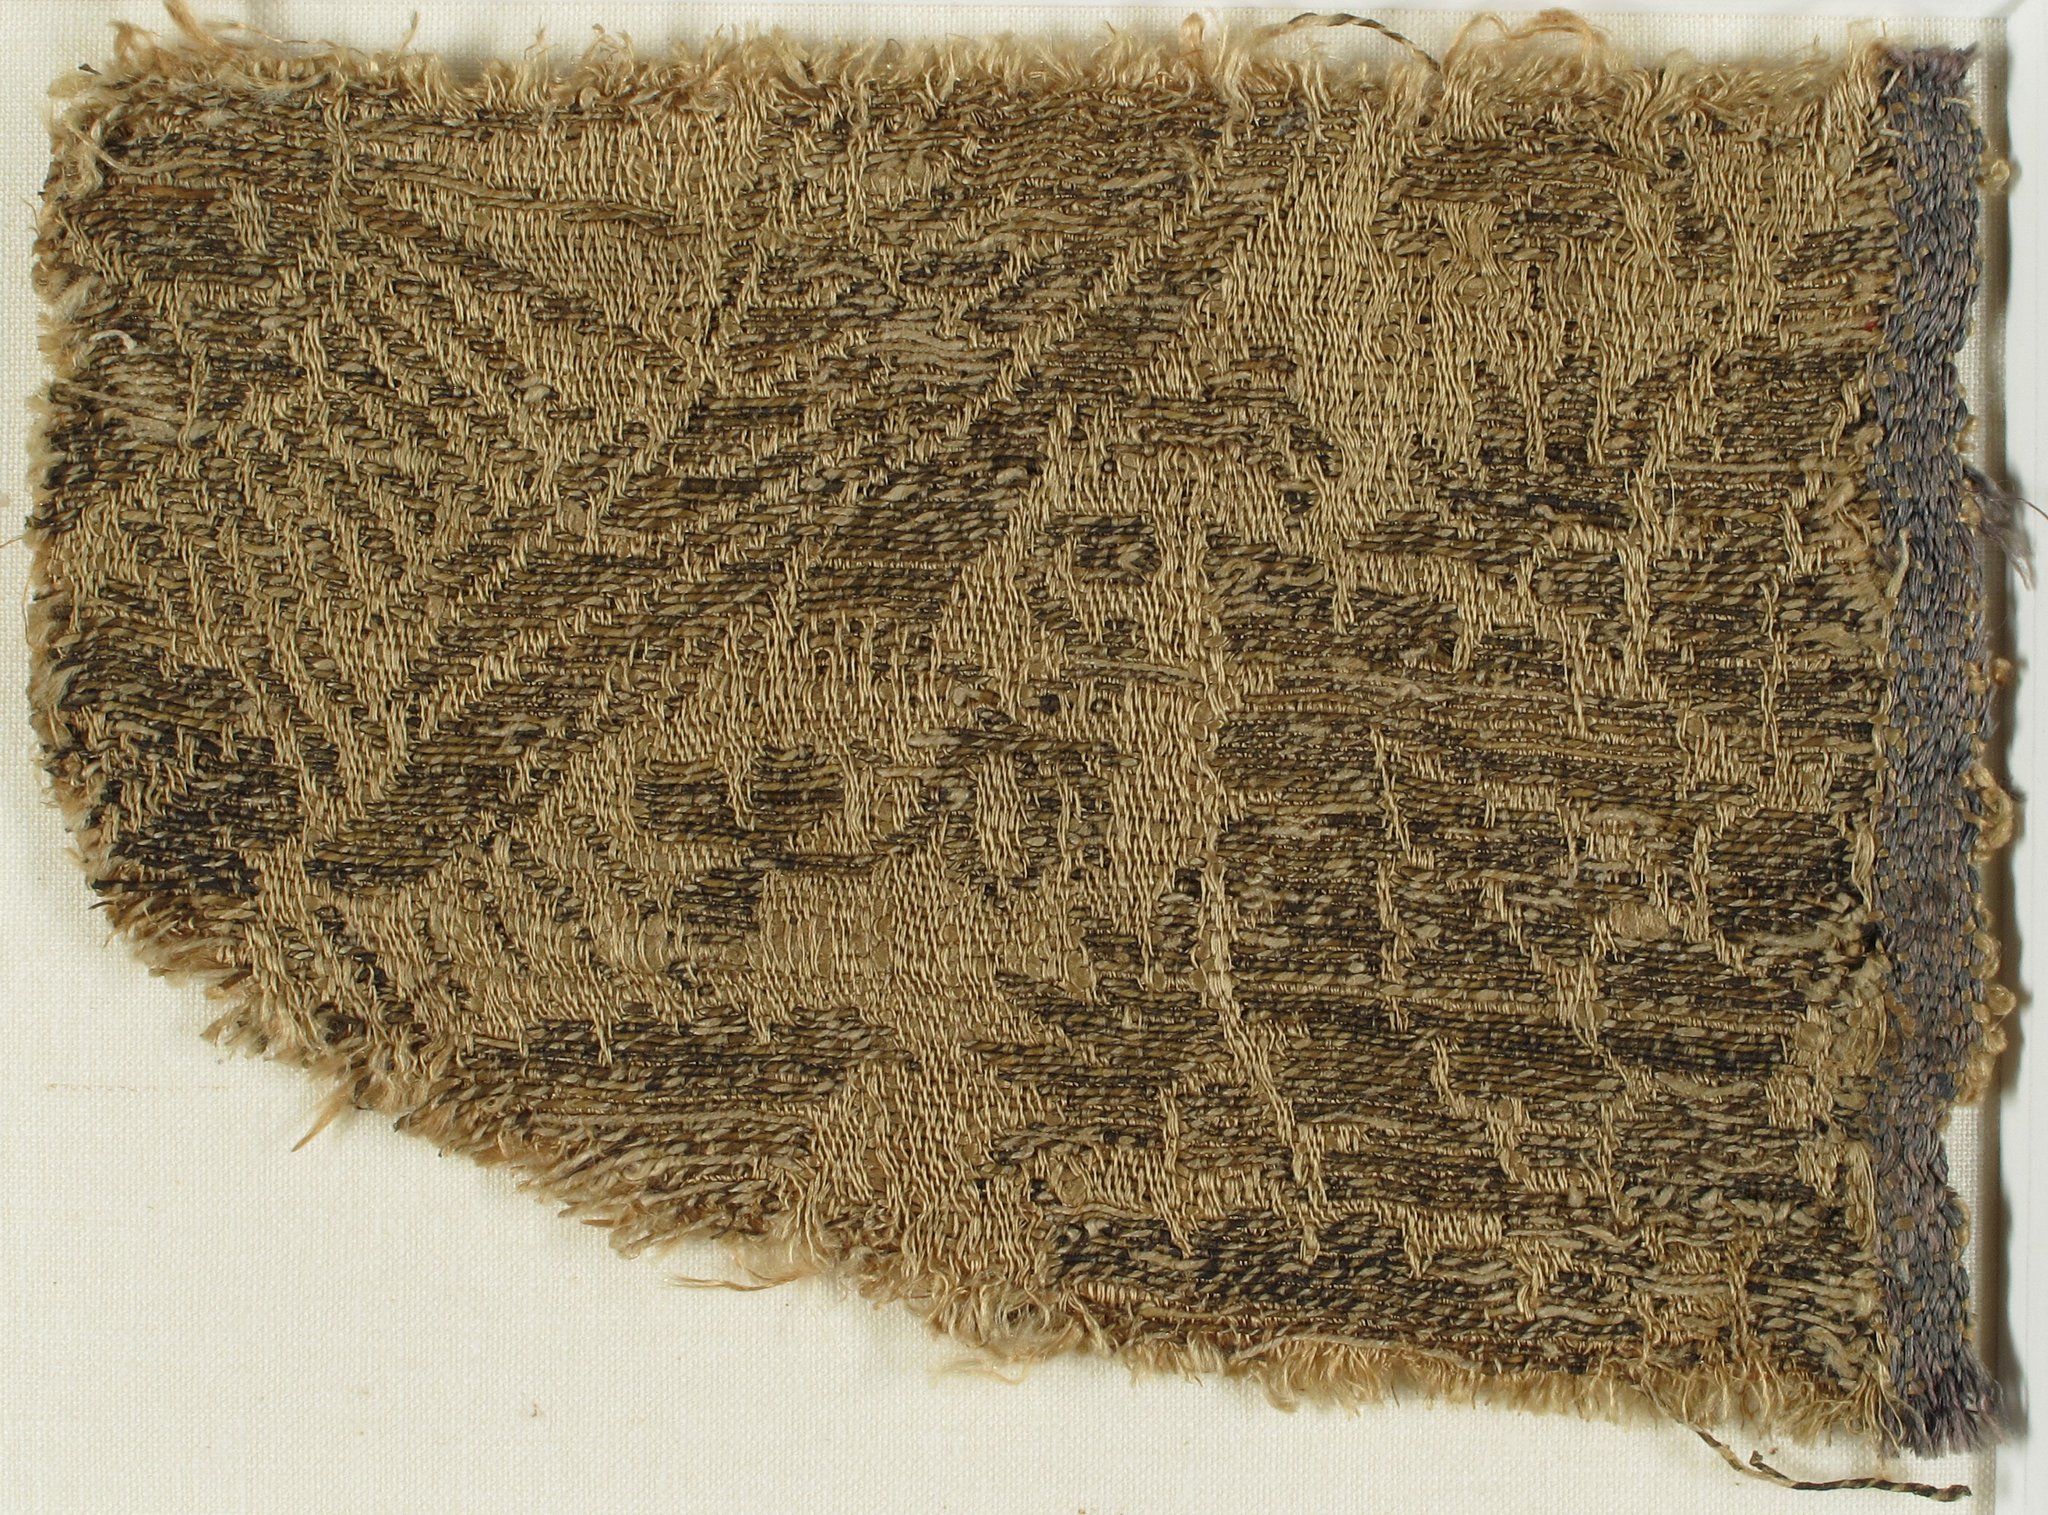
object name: textile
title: Textile with Eagle, Rayed Sun, and Flowers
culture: italo-arabic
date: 1301-1400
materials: gold thread, silk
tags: eagles,sun,flowers